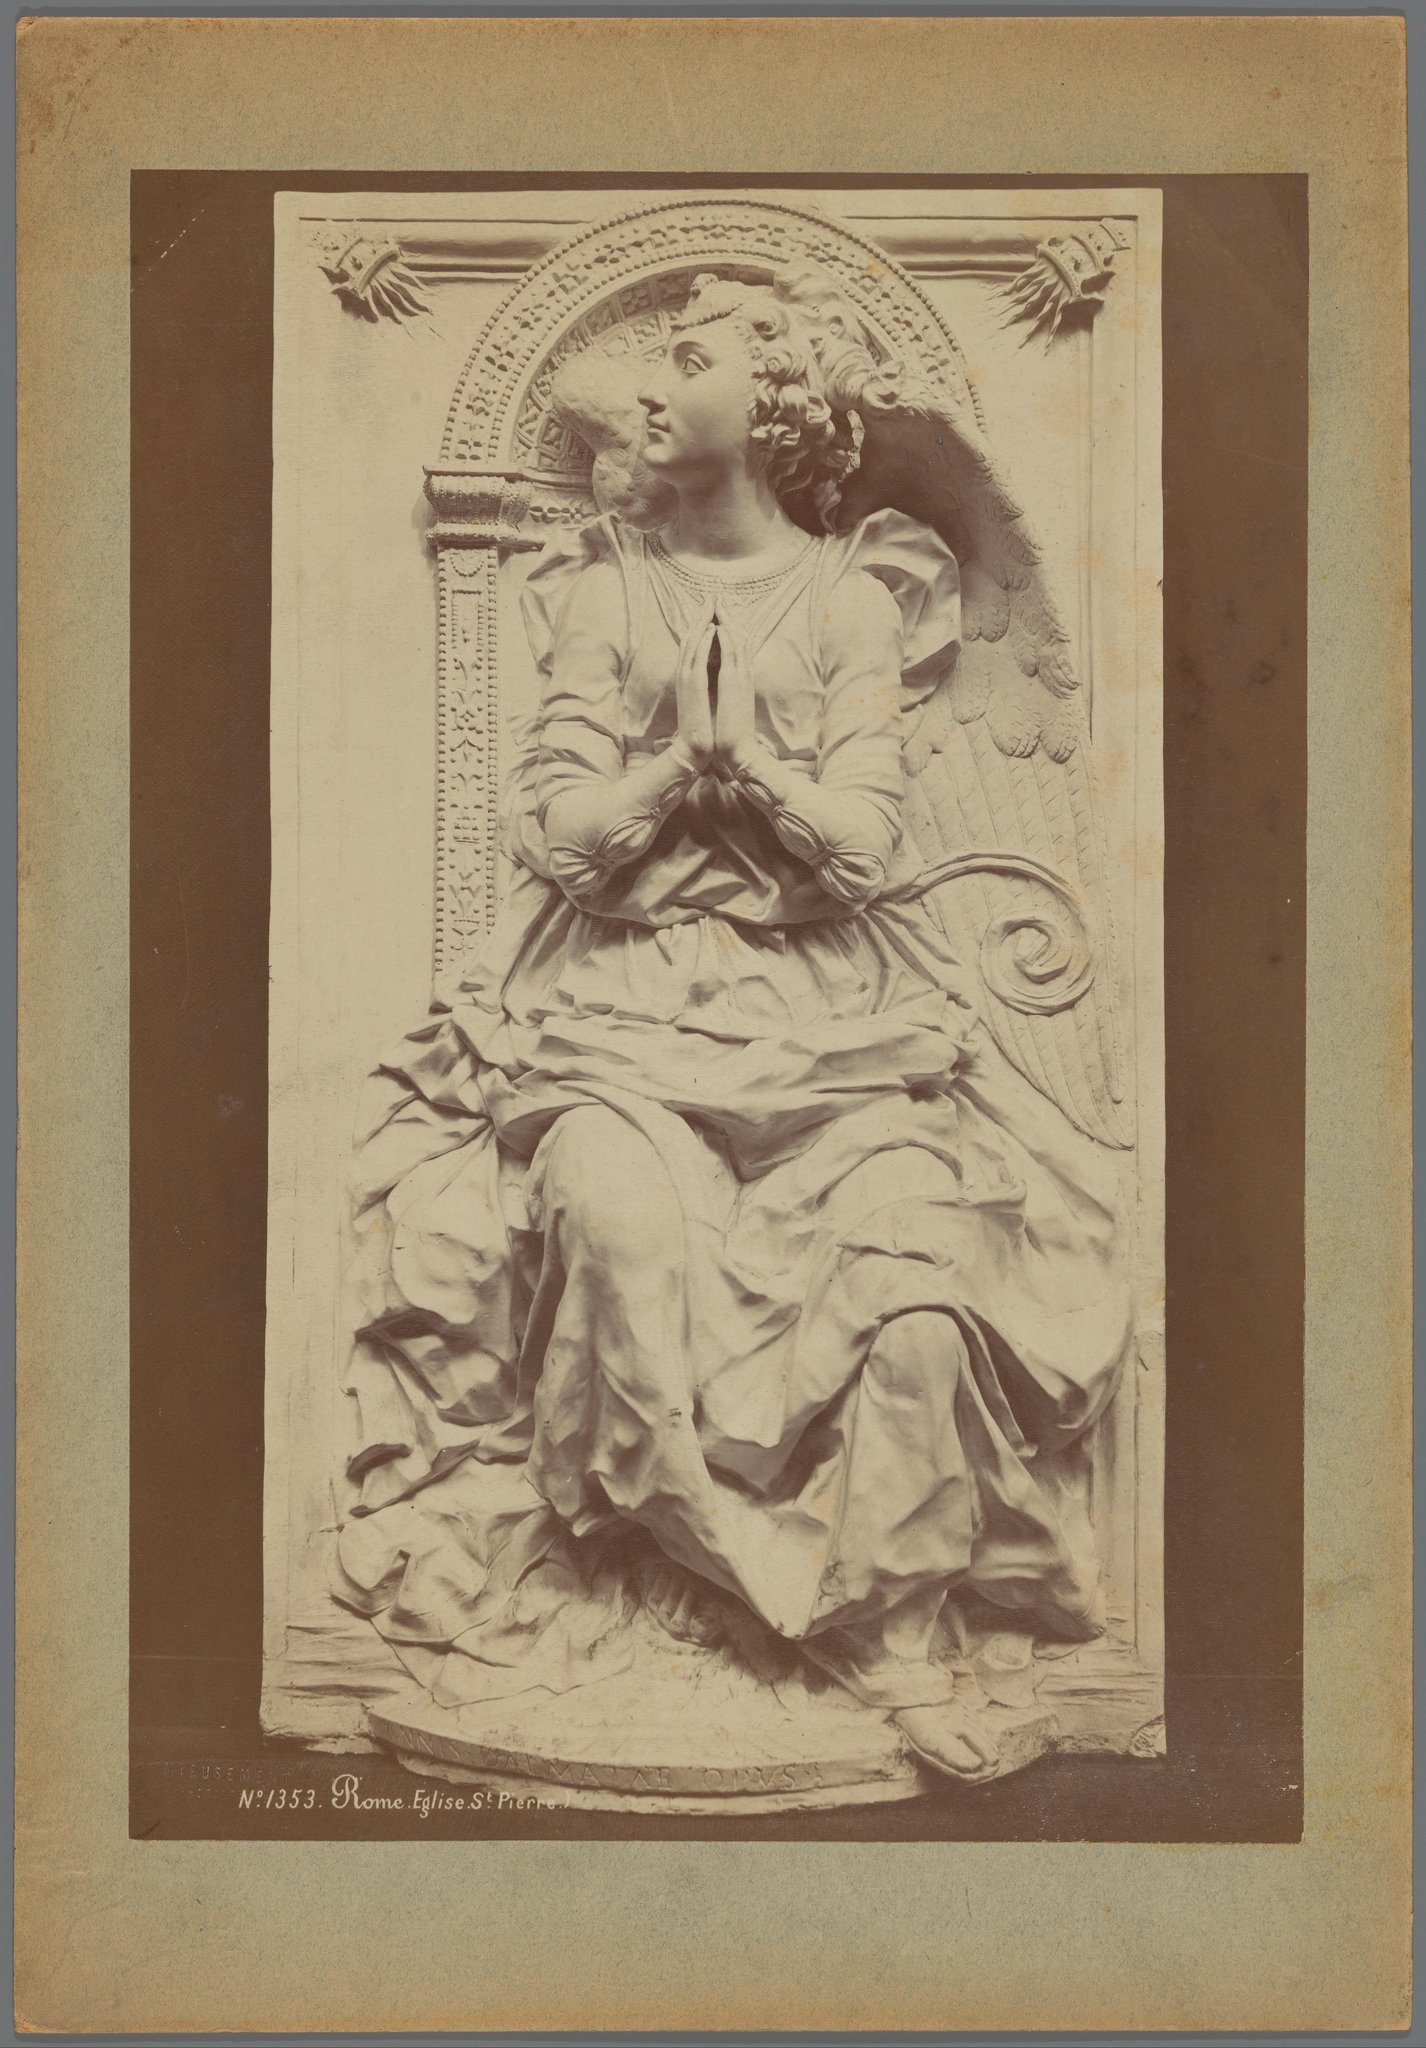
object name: photograph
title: Rome. Eglise St. Pierre.)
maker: séraphin-médéric mieusement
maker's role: fotograaf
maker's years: 1840-1905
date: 1875-1900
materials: cardboard, photographic support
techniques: albumen print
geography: palais du trocadéro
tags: permanent exhibition, museum, angels, sculpture (+ relief ~ sculpture)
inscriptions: number: ‘No. 1353.’, name: ‘MIEUSEMENT PHOTOGRAPHE’, name: ‘KUNSTBOEKHANDEL J. A. G. DE LEUR PHOTOGRAAF - UITGEVER HUIGENSPARK, 40b. DEN HAAG.’, inscription: ‘MONUMENTS HISTORIQUES’, collector's mark: Lugt 3937